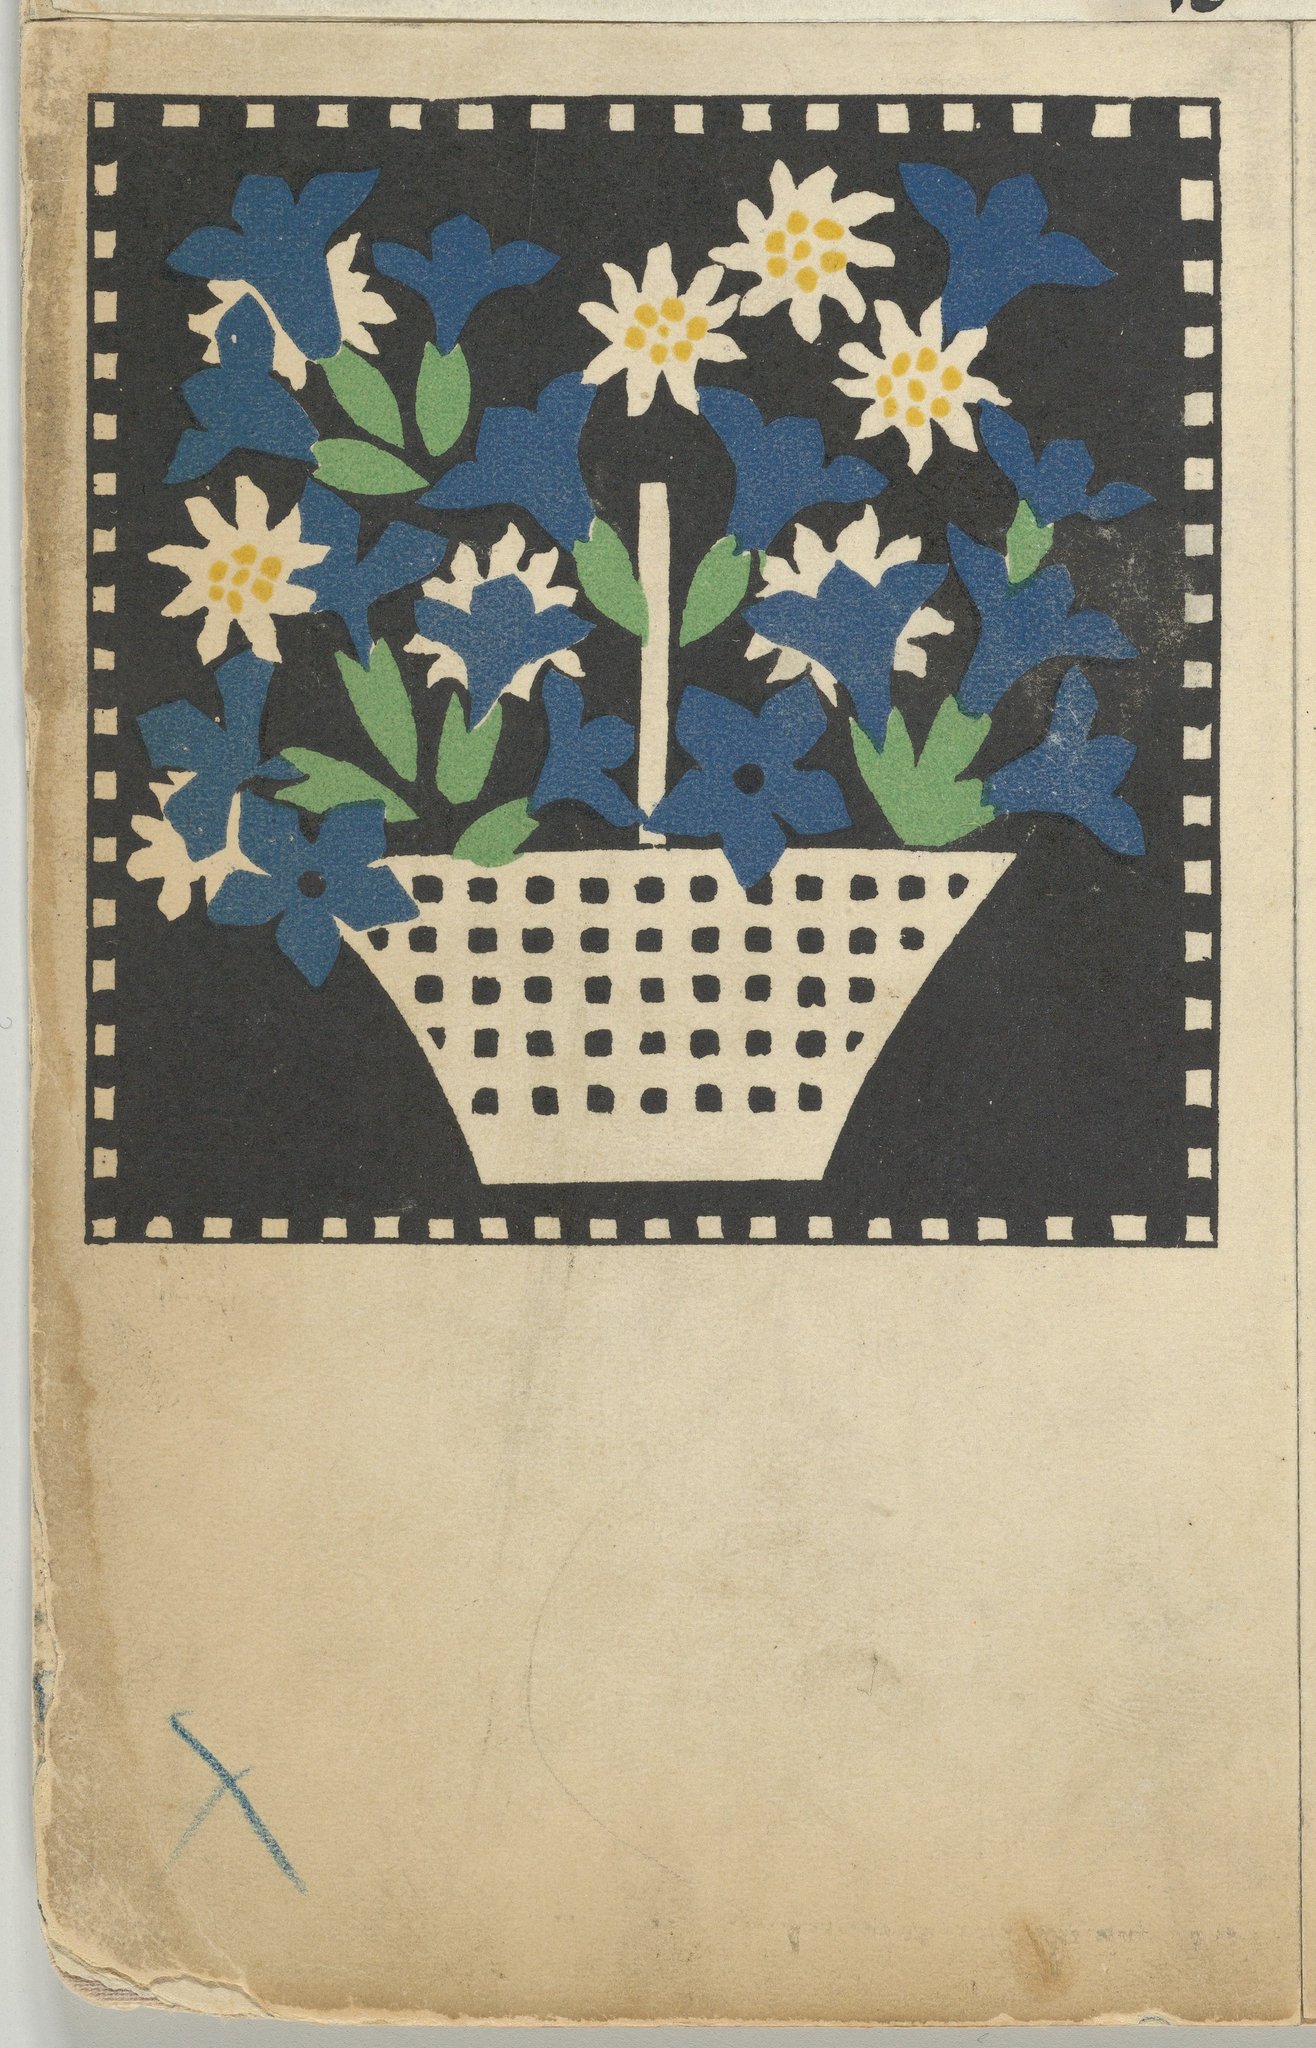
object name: print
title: Basket of Flowers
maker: leopoldine kolbe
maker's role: artist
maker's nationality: austrian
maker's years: 1870-1912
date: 1907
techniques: lithograph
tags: flowers